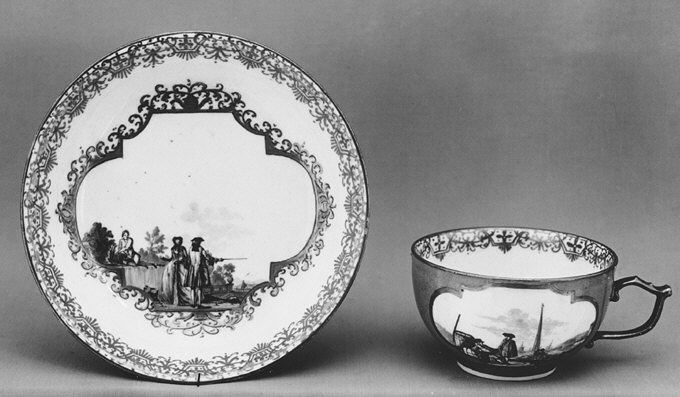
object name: cup and saucer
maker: meissen manufactory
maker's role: manufactory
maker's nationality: german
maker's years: 1710-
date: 1740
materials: hard paste porcelain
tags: human figures